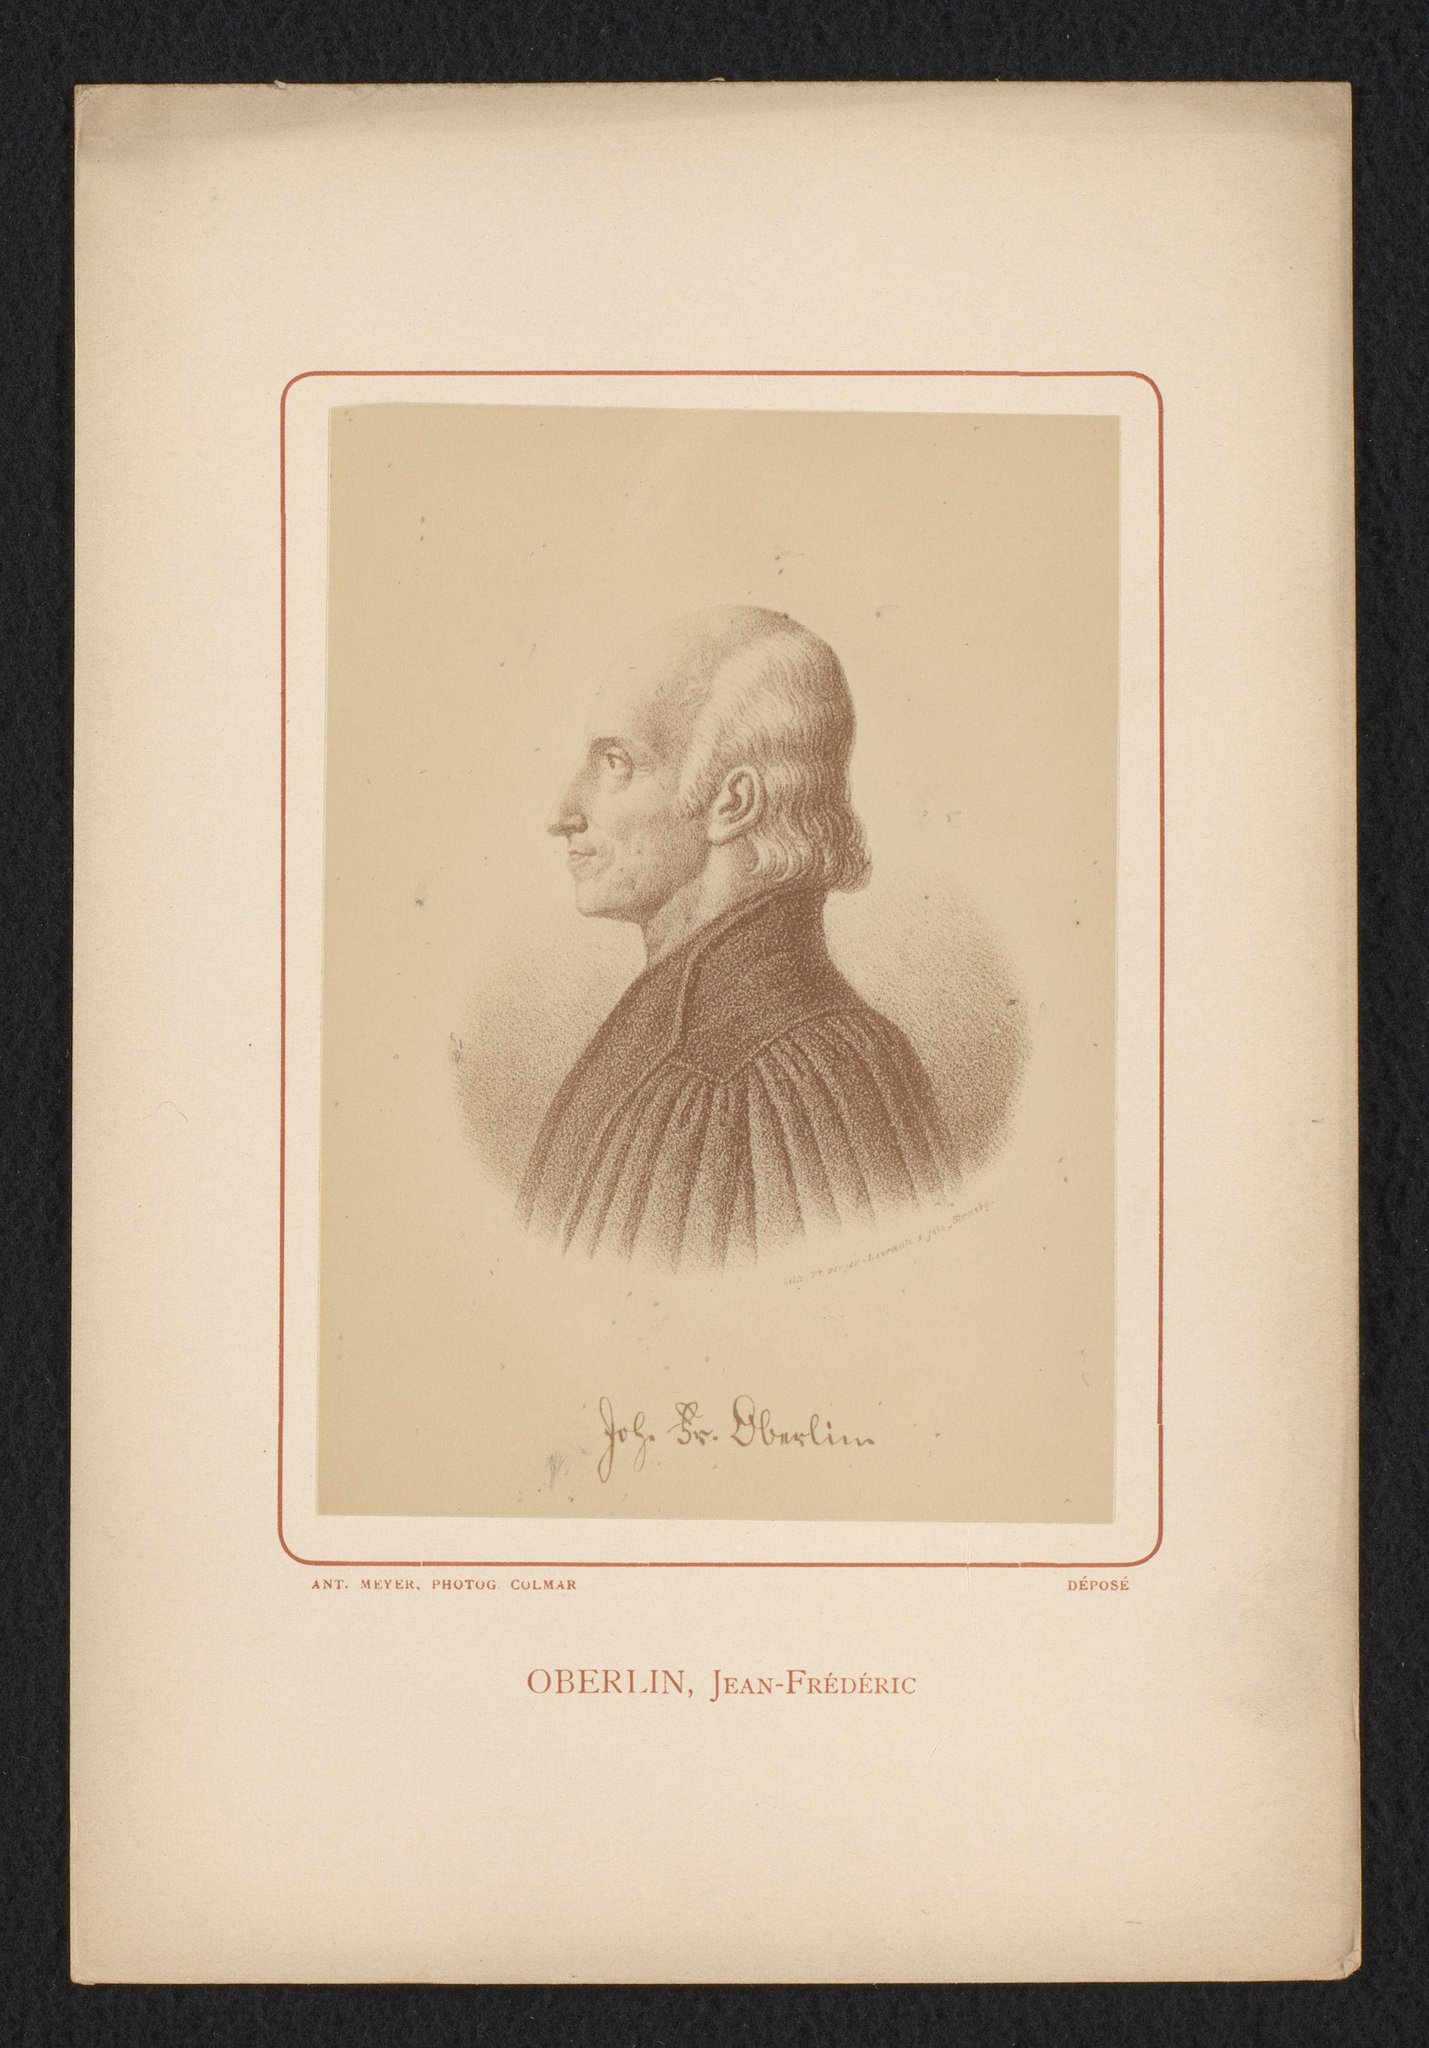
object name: photograph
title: Fotoreproductie van een prent van een portret van Jean-Frédéric Oberlin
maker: anton meyer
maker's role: fotograaf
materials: photographic support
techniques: albumen print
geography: colmar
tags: theologian, historical persons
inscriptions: inscription: ‘Déposé’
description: Deze foto maakt deel uit van een omslag met 29 foto's op 29 bladen en 23 teksbladen.